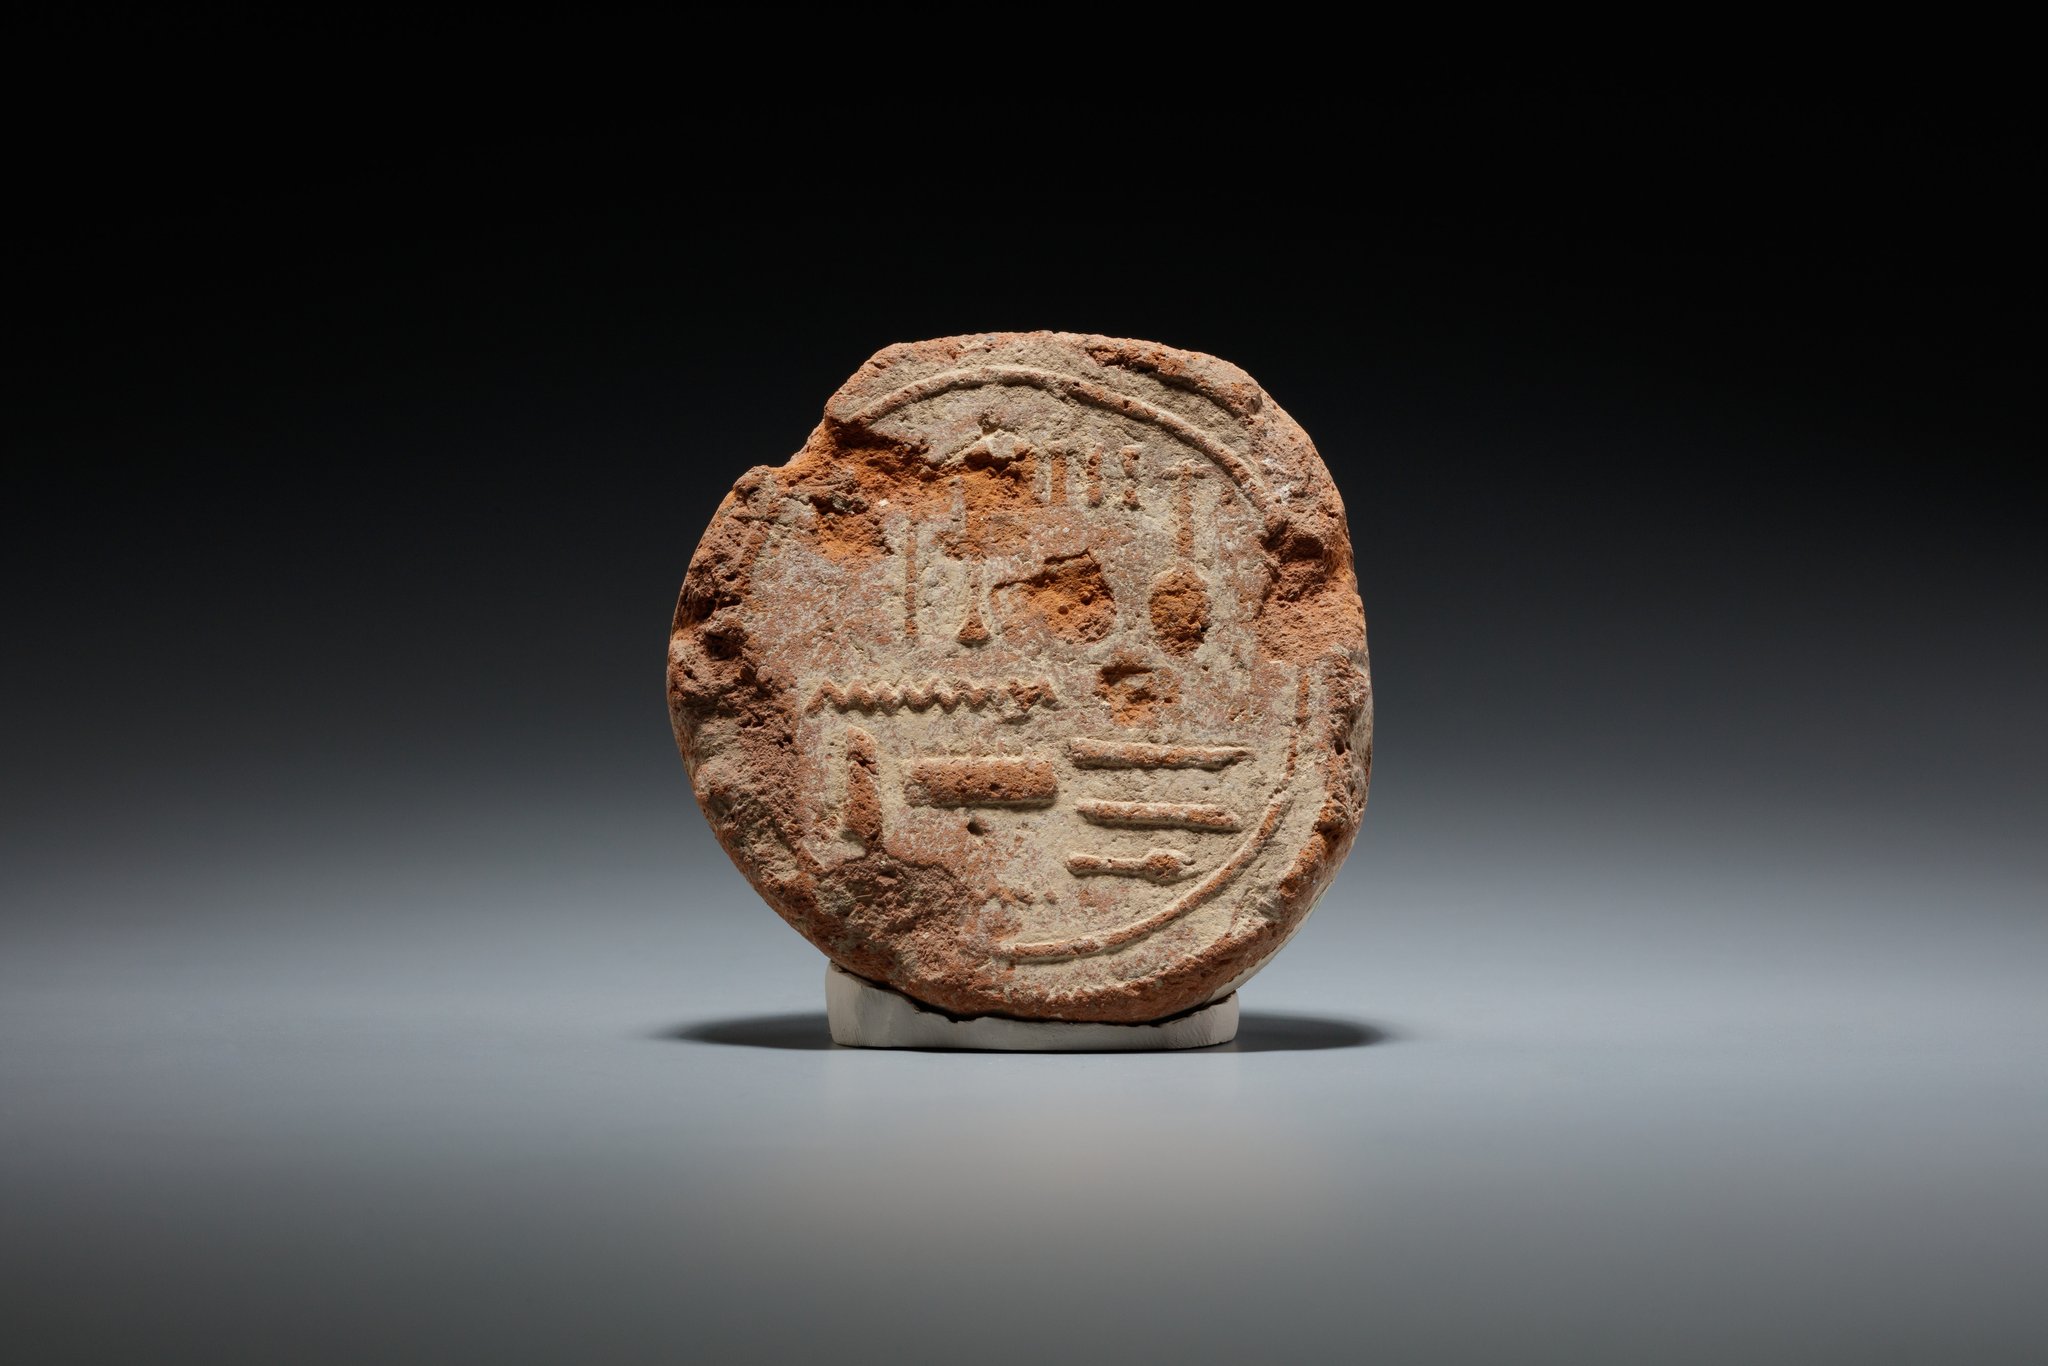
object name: cone, davy 301, neferhotep, fourth priest, amun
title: Funerary Cone of the Fourth Prophet of Amun Neferhotep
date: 1550-1295 BCE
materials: pottery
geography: egypt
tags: hieroglyphs